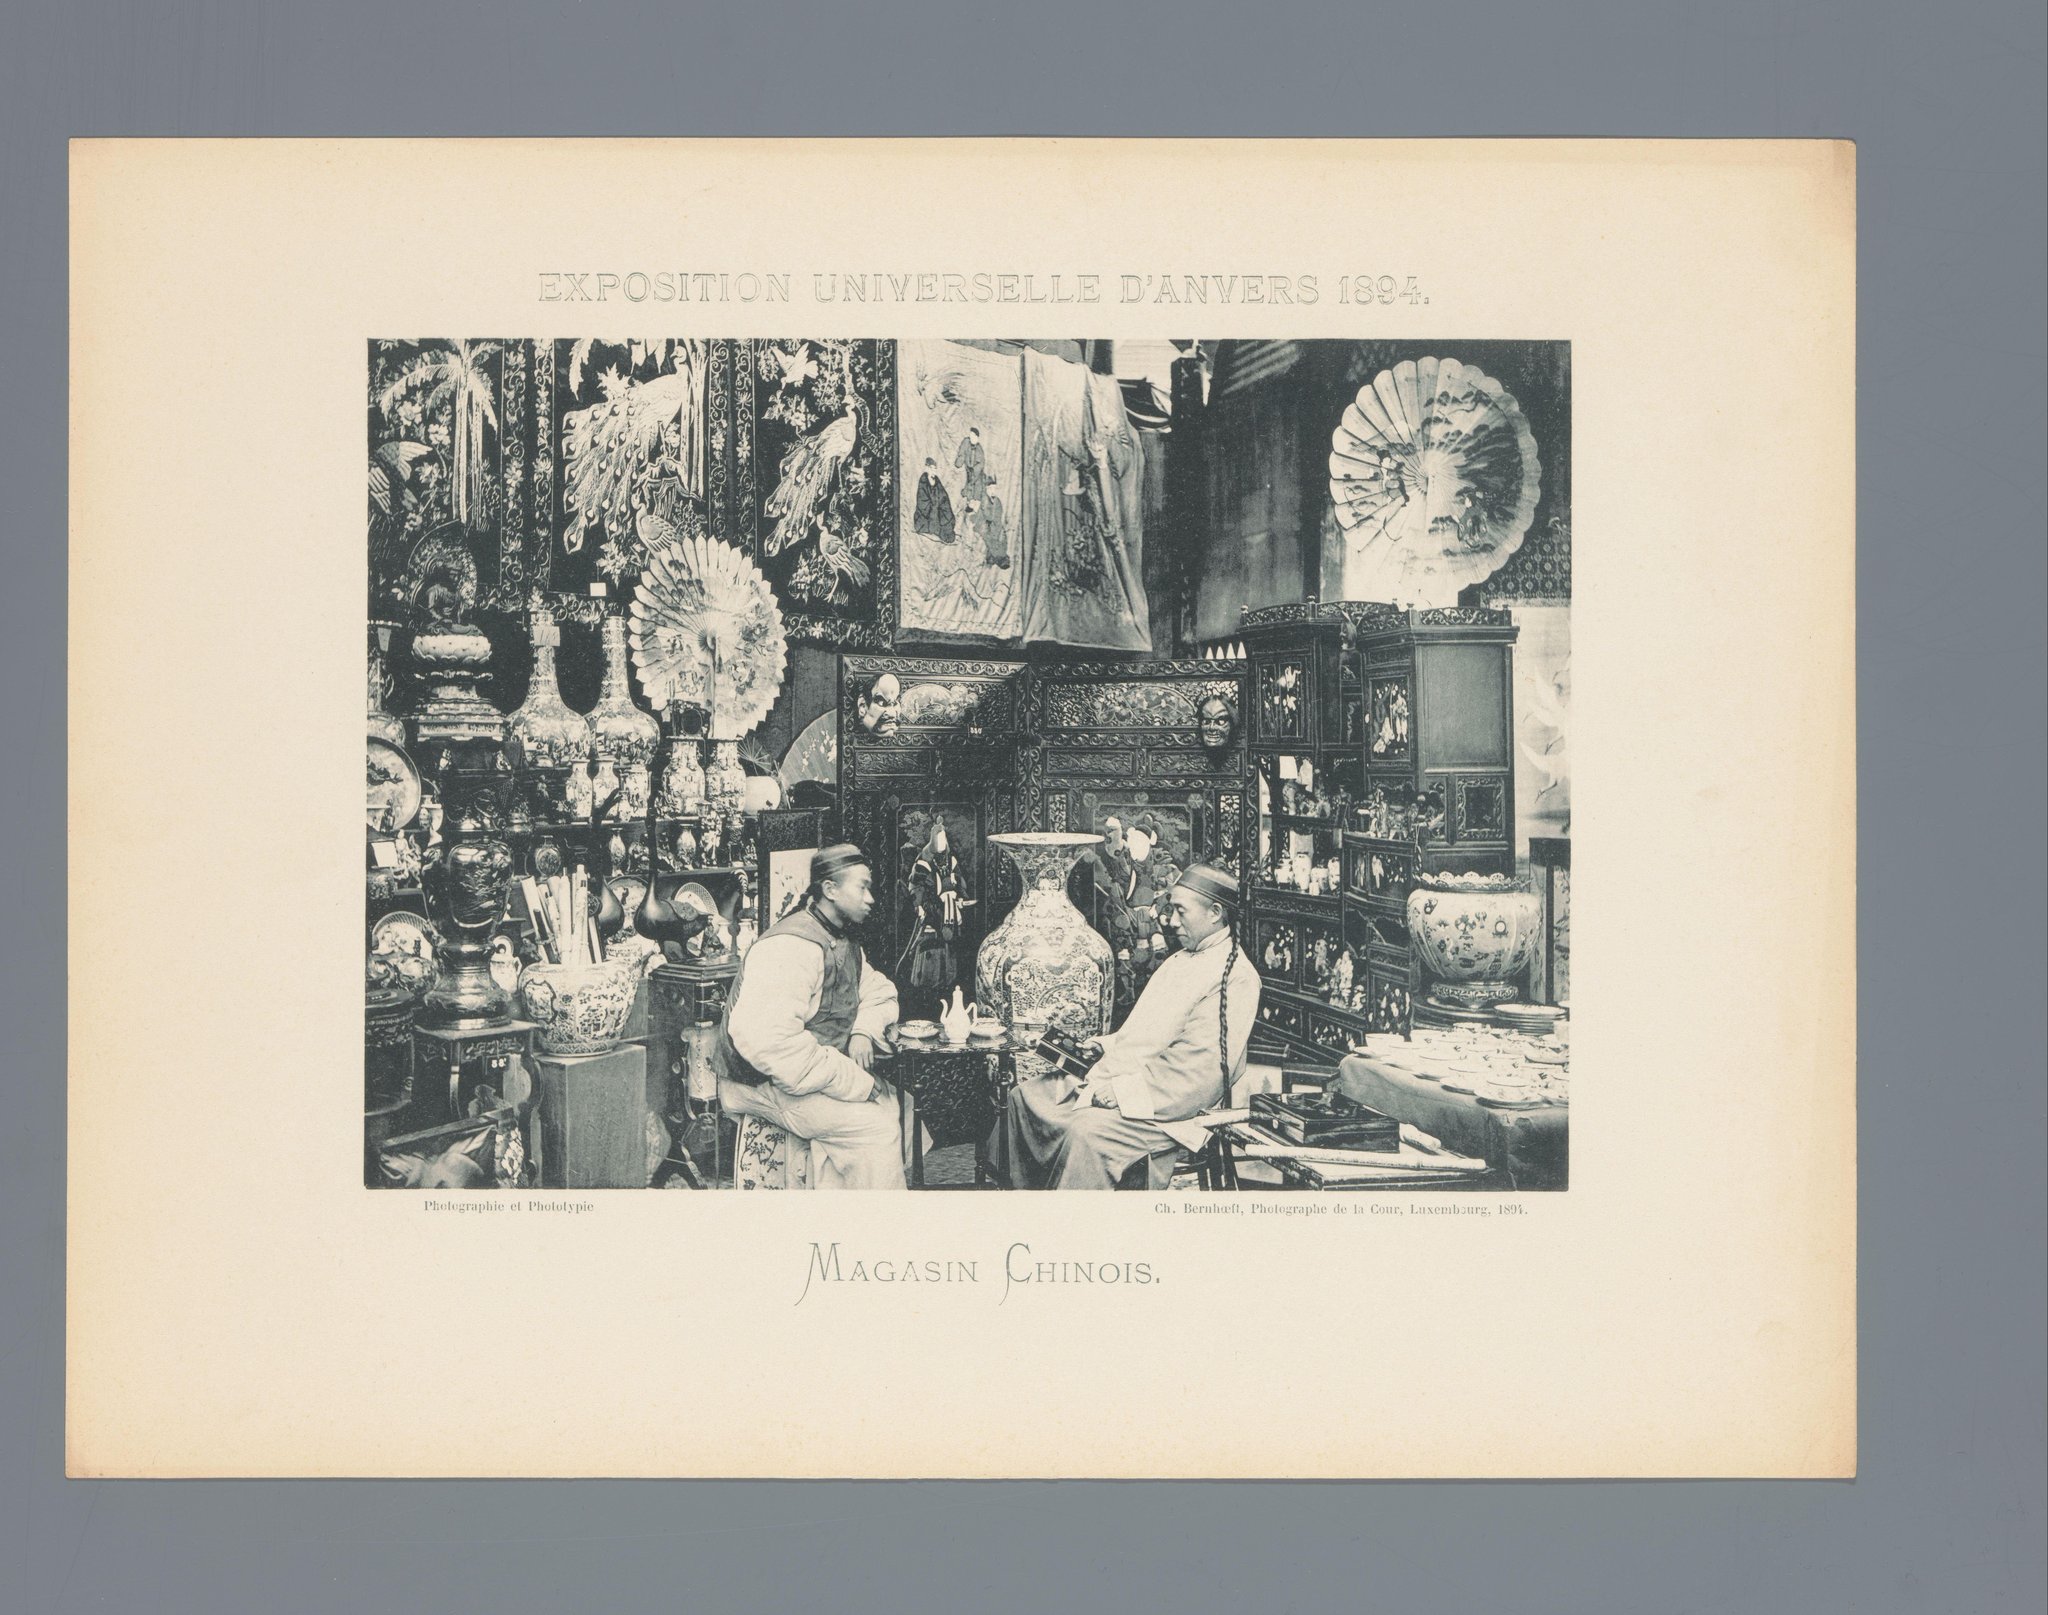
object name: photomechanical print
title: Magasin chinoise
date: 1894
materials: paper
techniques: photograph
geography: antwerp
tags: chinese, world fair, world exhibition, historical persons, antwerp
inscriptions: inscription: ‘Exposition Universelle D'Anvers 1894.’